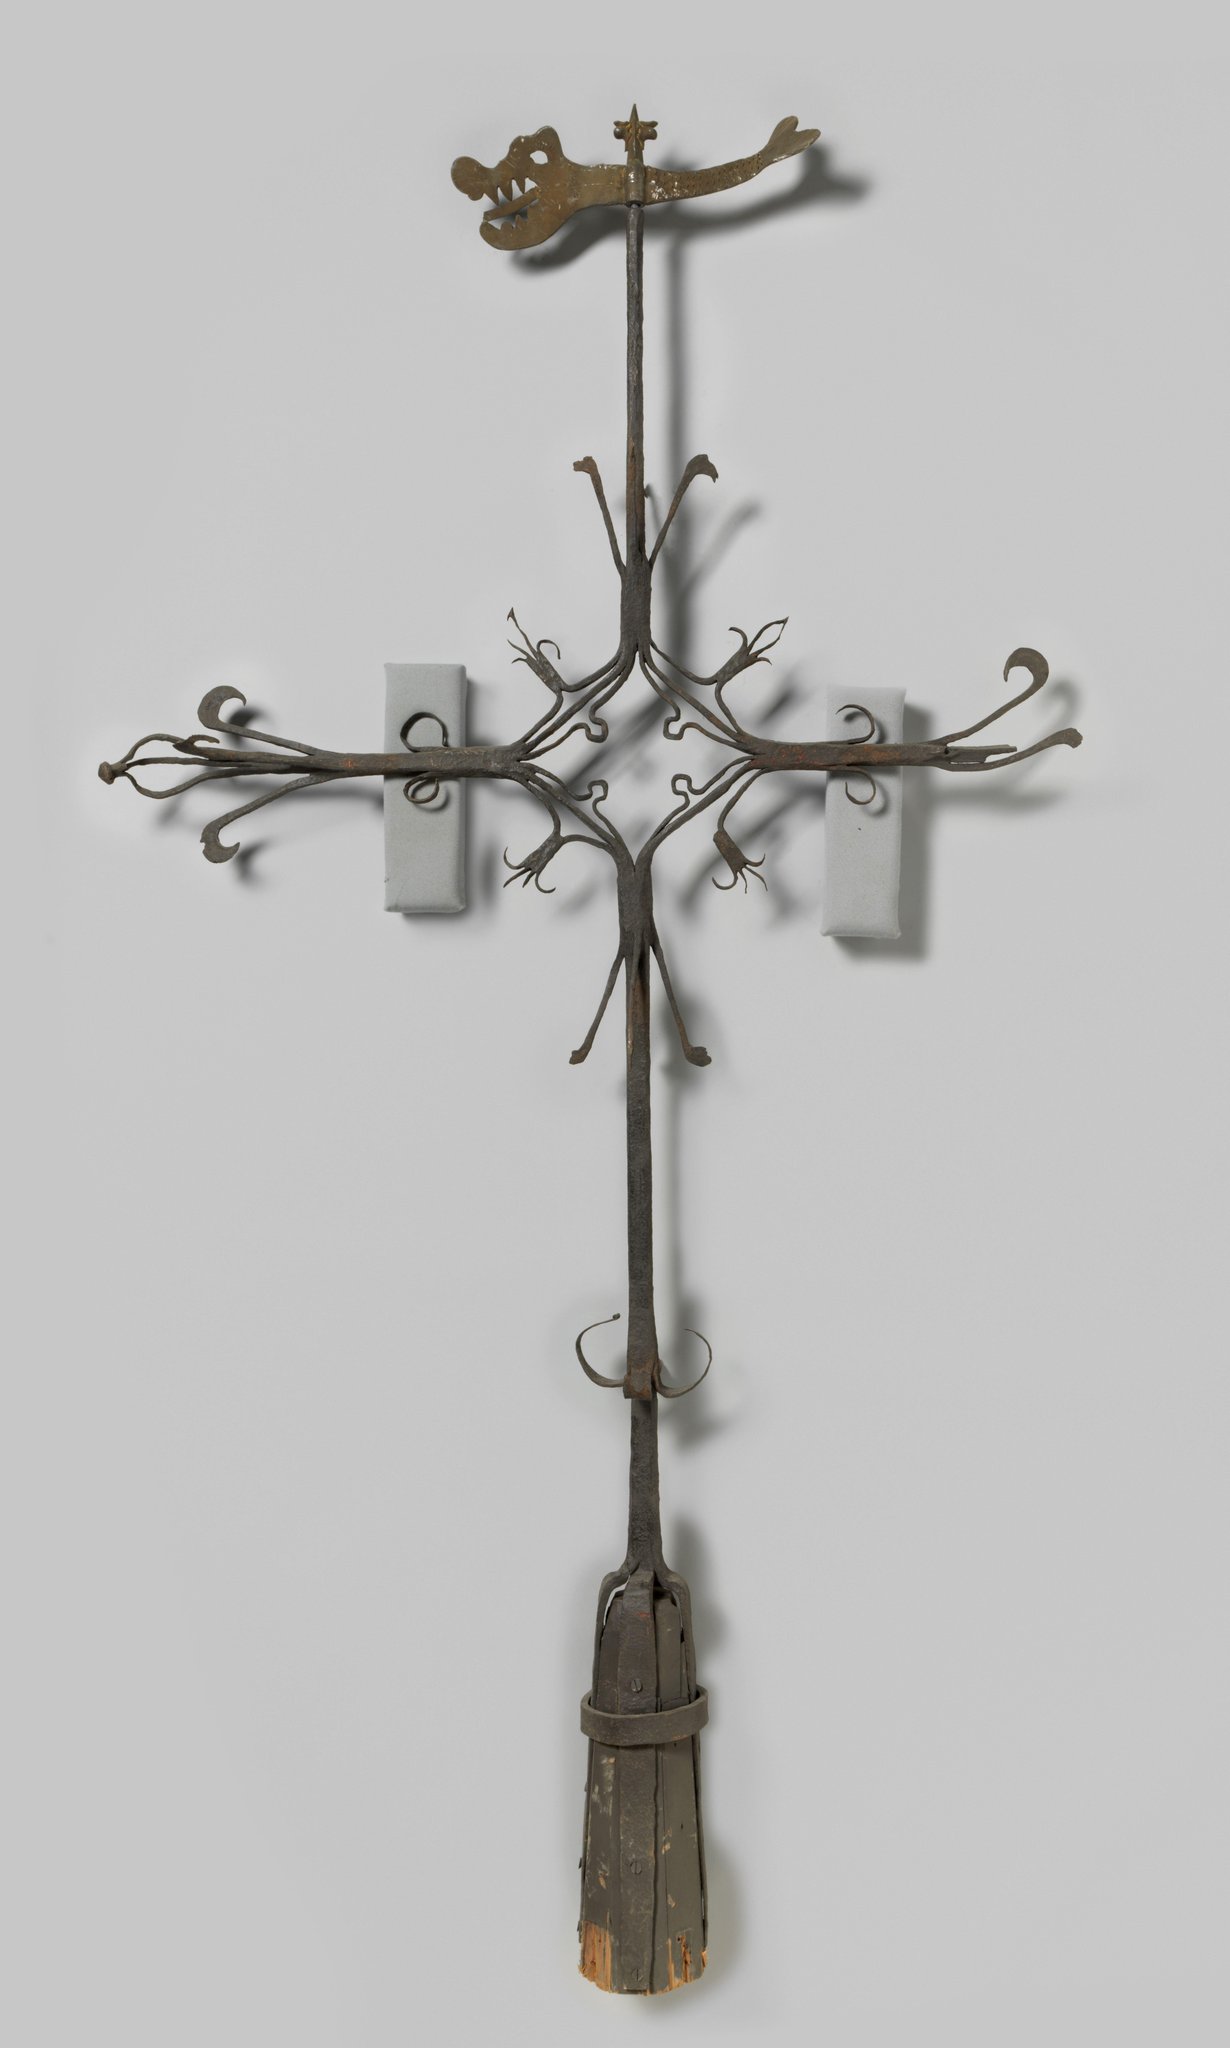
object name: torenkruis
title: Torenkruis waarvan de dwarsarmen eindigen in lelies. Windvaan in vorm zeemonster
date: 1400-1500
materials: iron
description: Een kruis van een torenspits of kerkdak, de dwarsarm eindigende in een lelie van gesmeed ijzer. Met windvaan, in de vorm van een zeemonster, en twee ringen ter bevestiging op de nokspits.